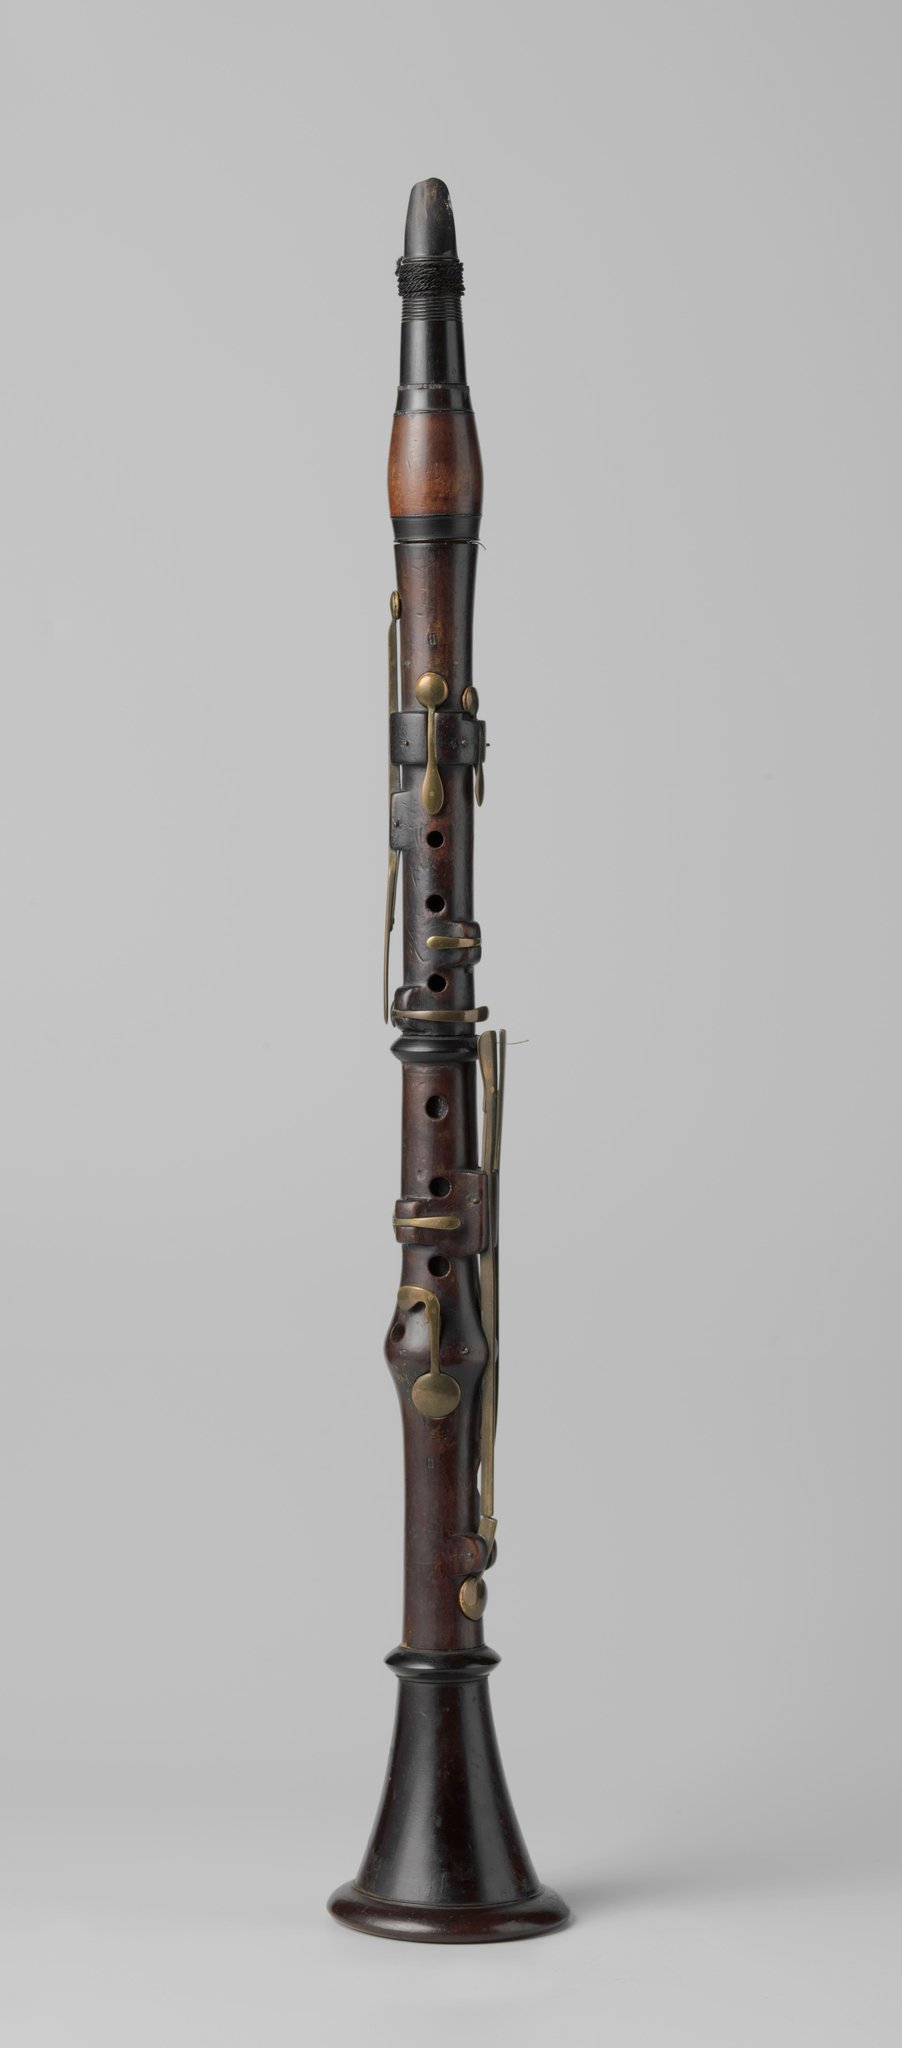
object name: wind instrument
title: Clarinet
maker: Anonymous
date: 1830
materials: copper, wood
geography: europe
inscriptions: inscription, stamped: ‘RA[...]’